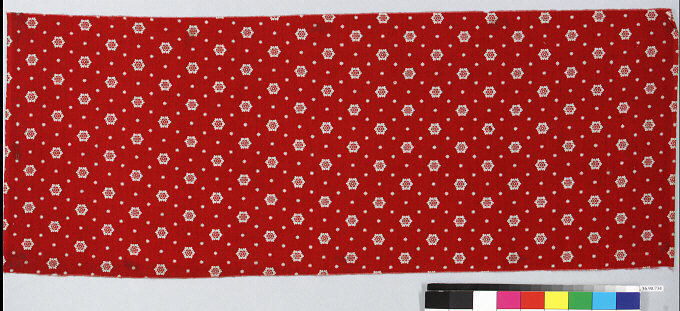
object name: piece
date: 1867-1900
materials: cotton